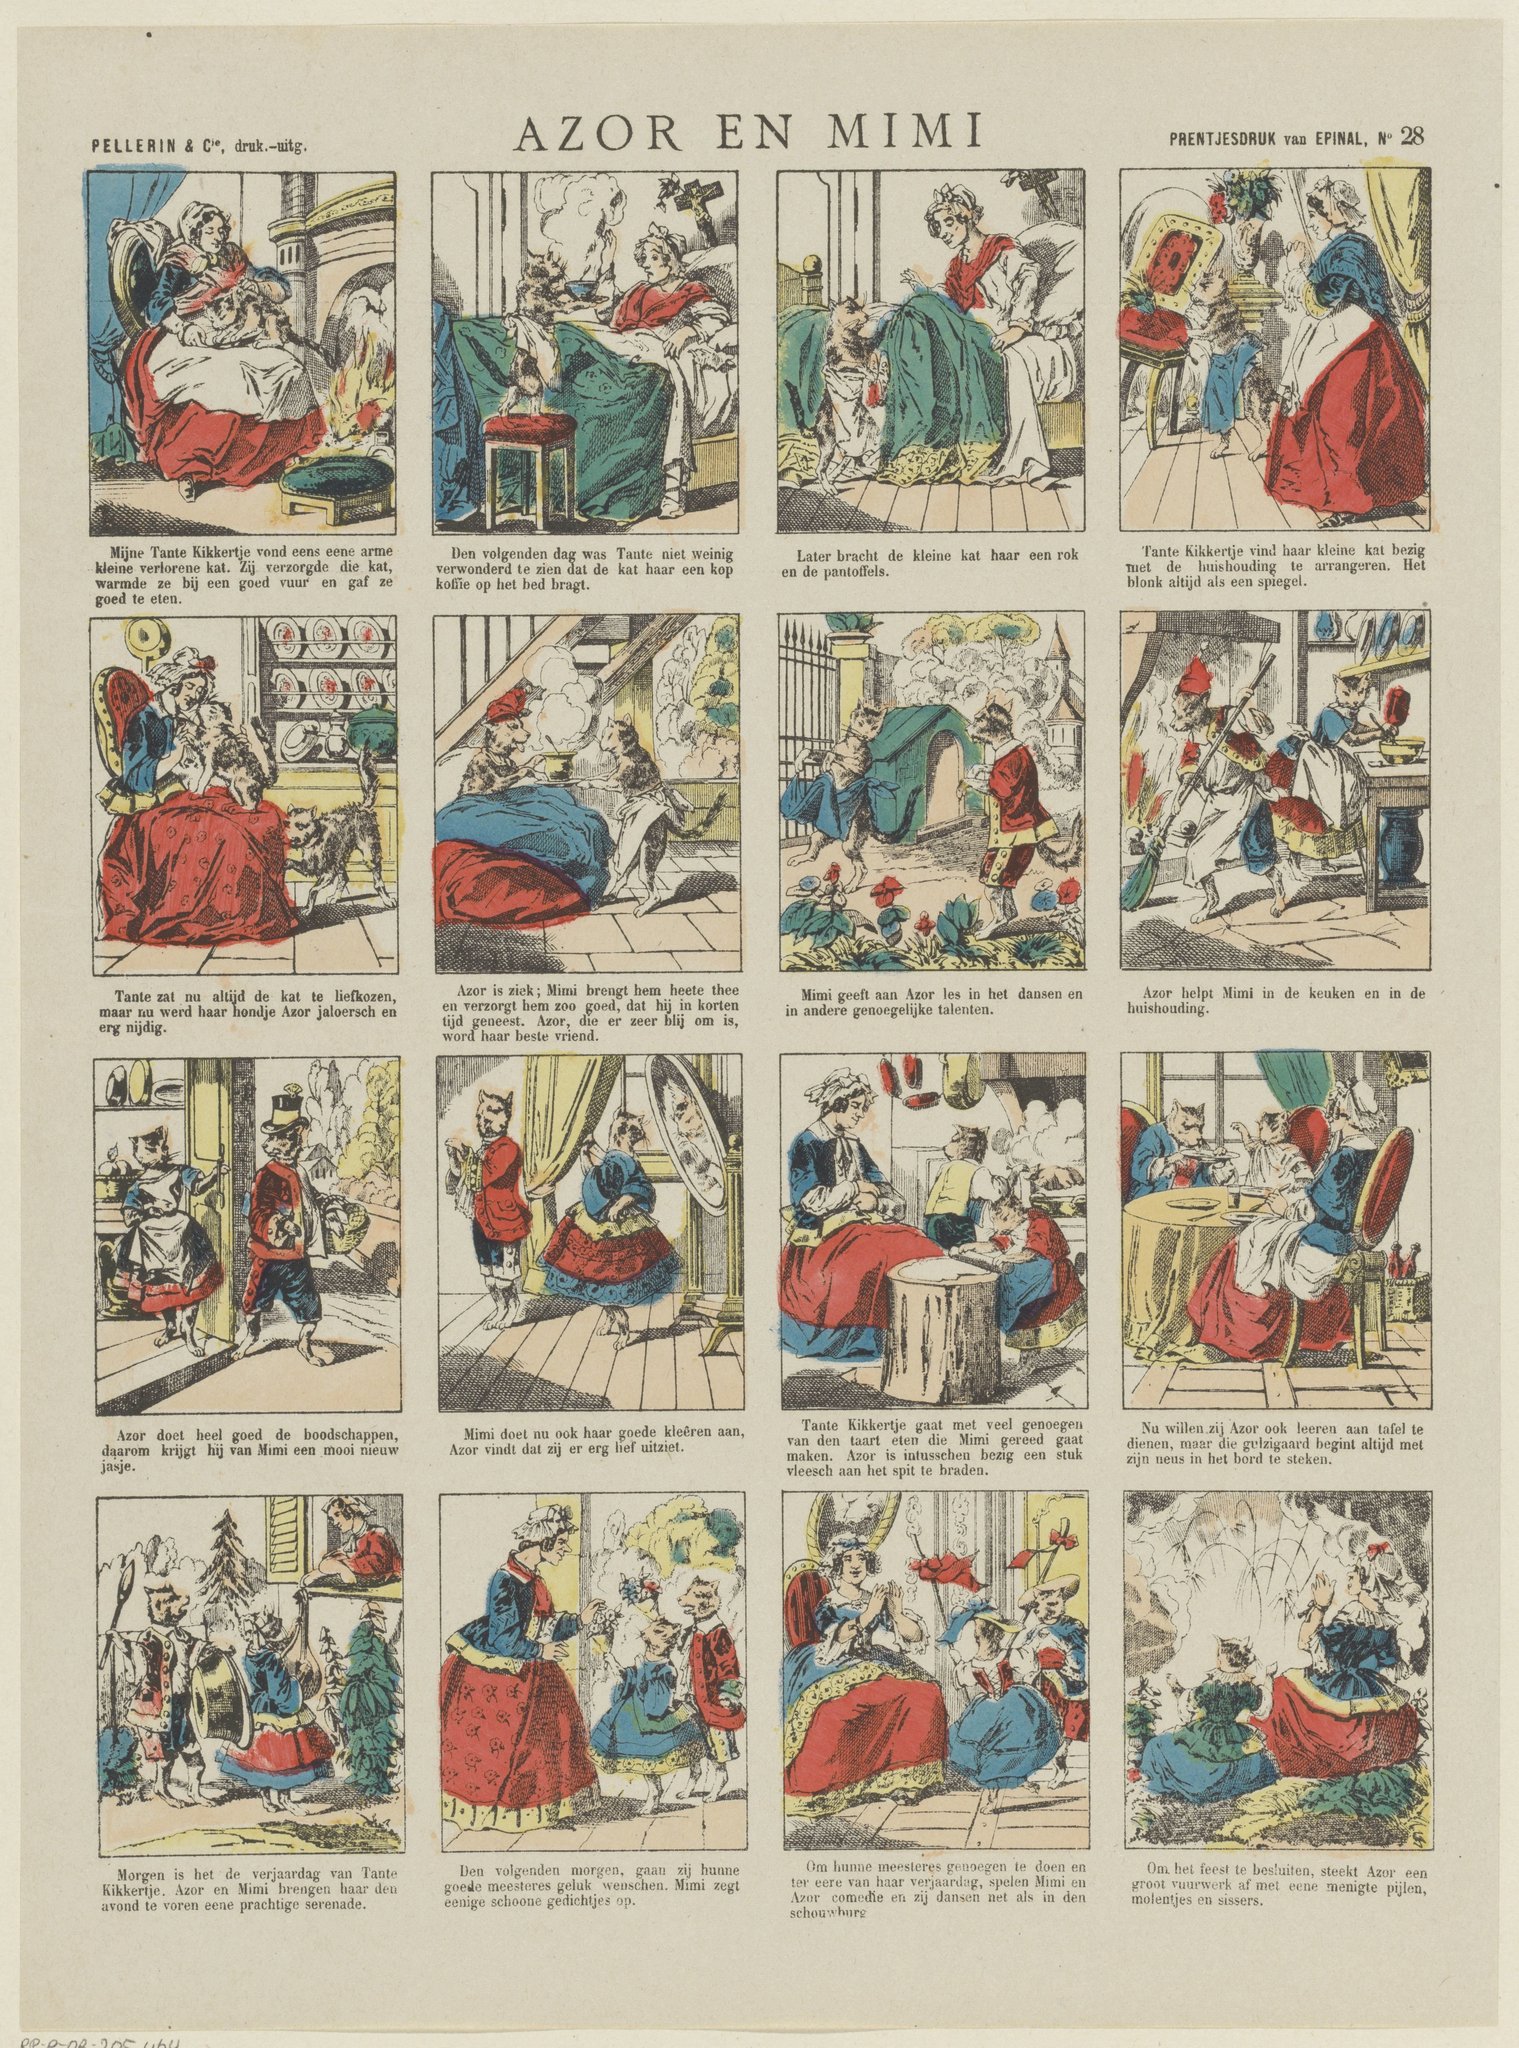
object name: print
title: Prentjesdruk van Épinal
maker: Anonymous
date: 1902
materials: paper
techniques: colour, letterpress printing, lithograph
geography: epinal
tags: cat, animals acting as human beings, tales and fairy tales, dog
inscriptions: collector's mark: Lugt 2760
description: Blad met 16 voorstellingen over de hond Azor en de kat Mimi. Onder elke afbeelding een onderschrift. Genummerd rechtsboven: No 28.